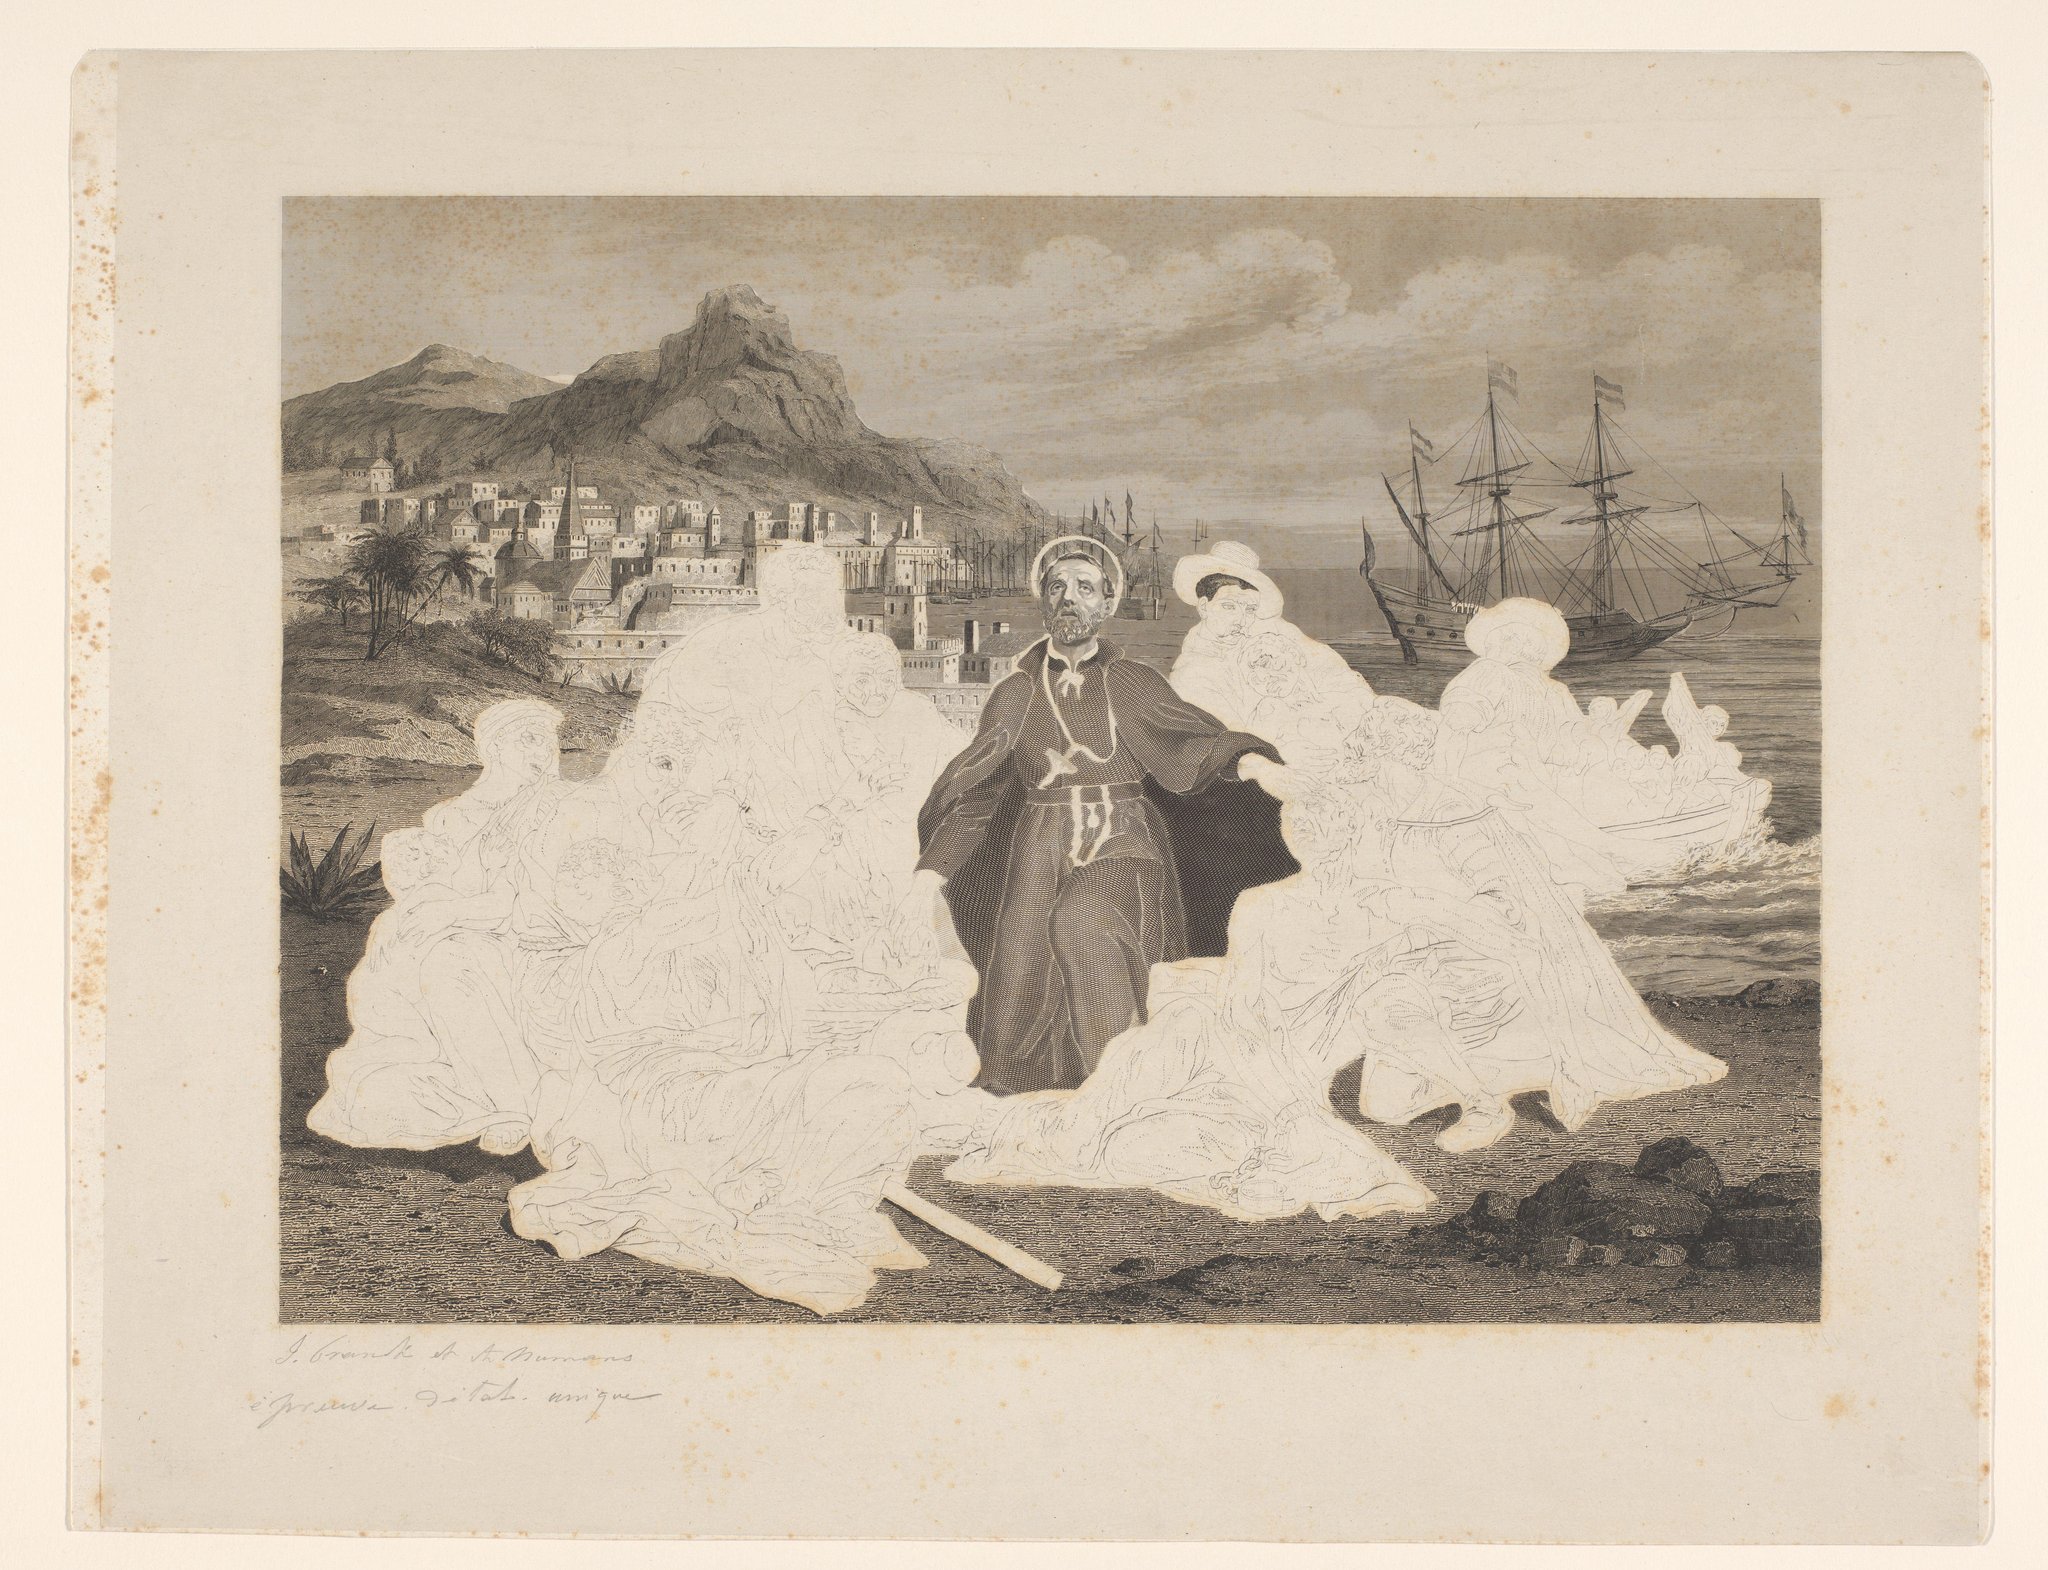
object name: print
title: Sint-Franciscus Xavier verricht wonderen bij slaafgemaakten in een kustlandschap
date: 1833-1883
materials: paper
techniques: engraving, etching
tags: st. francis xavier as missionary in the east indies performing miracles, slavery; serfs and enslaved persons, coast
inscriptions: inscription: ‘J. Franck et A Numans, epreuve d état unique’, collector's mark: Lugt 2228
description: Waarschijnlijk gaat het om wonderen die Sint-Franciscus Xavier verricht als missionaris onderweg naar of in Indië.